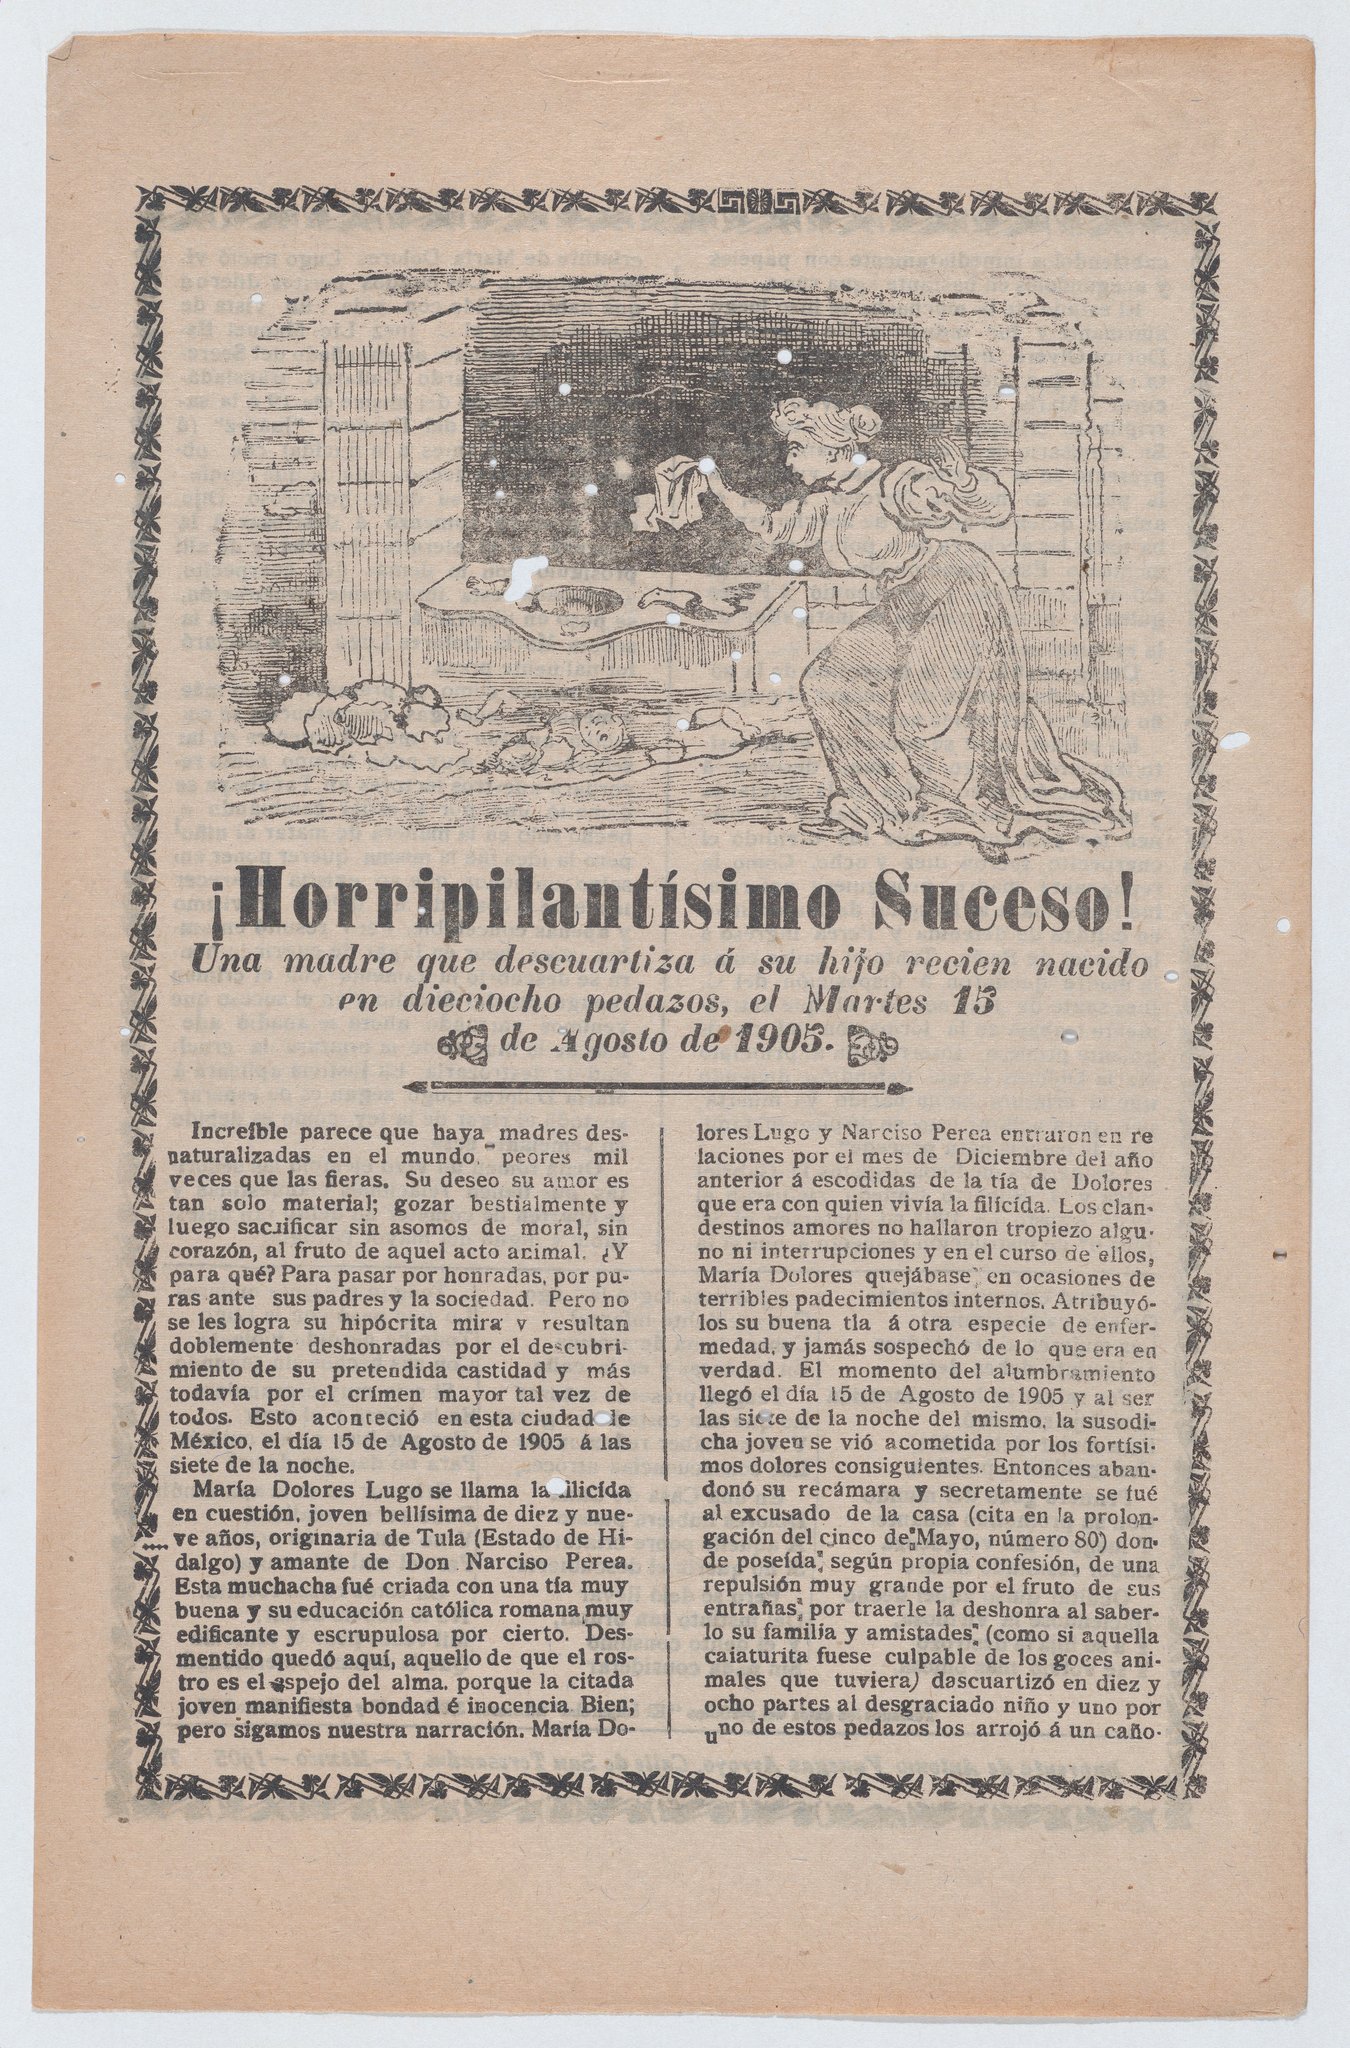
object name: print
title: Broadsheet relating to a news story about a young mother who dismembered her newborn, a woman discovering the scene of the crime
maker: josé guadalupe posada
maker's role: artist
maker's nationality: mexican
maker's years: 1852-1913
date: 1905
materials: paper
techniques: letterpress, lithography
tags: women,death,documents